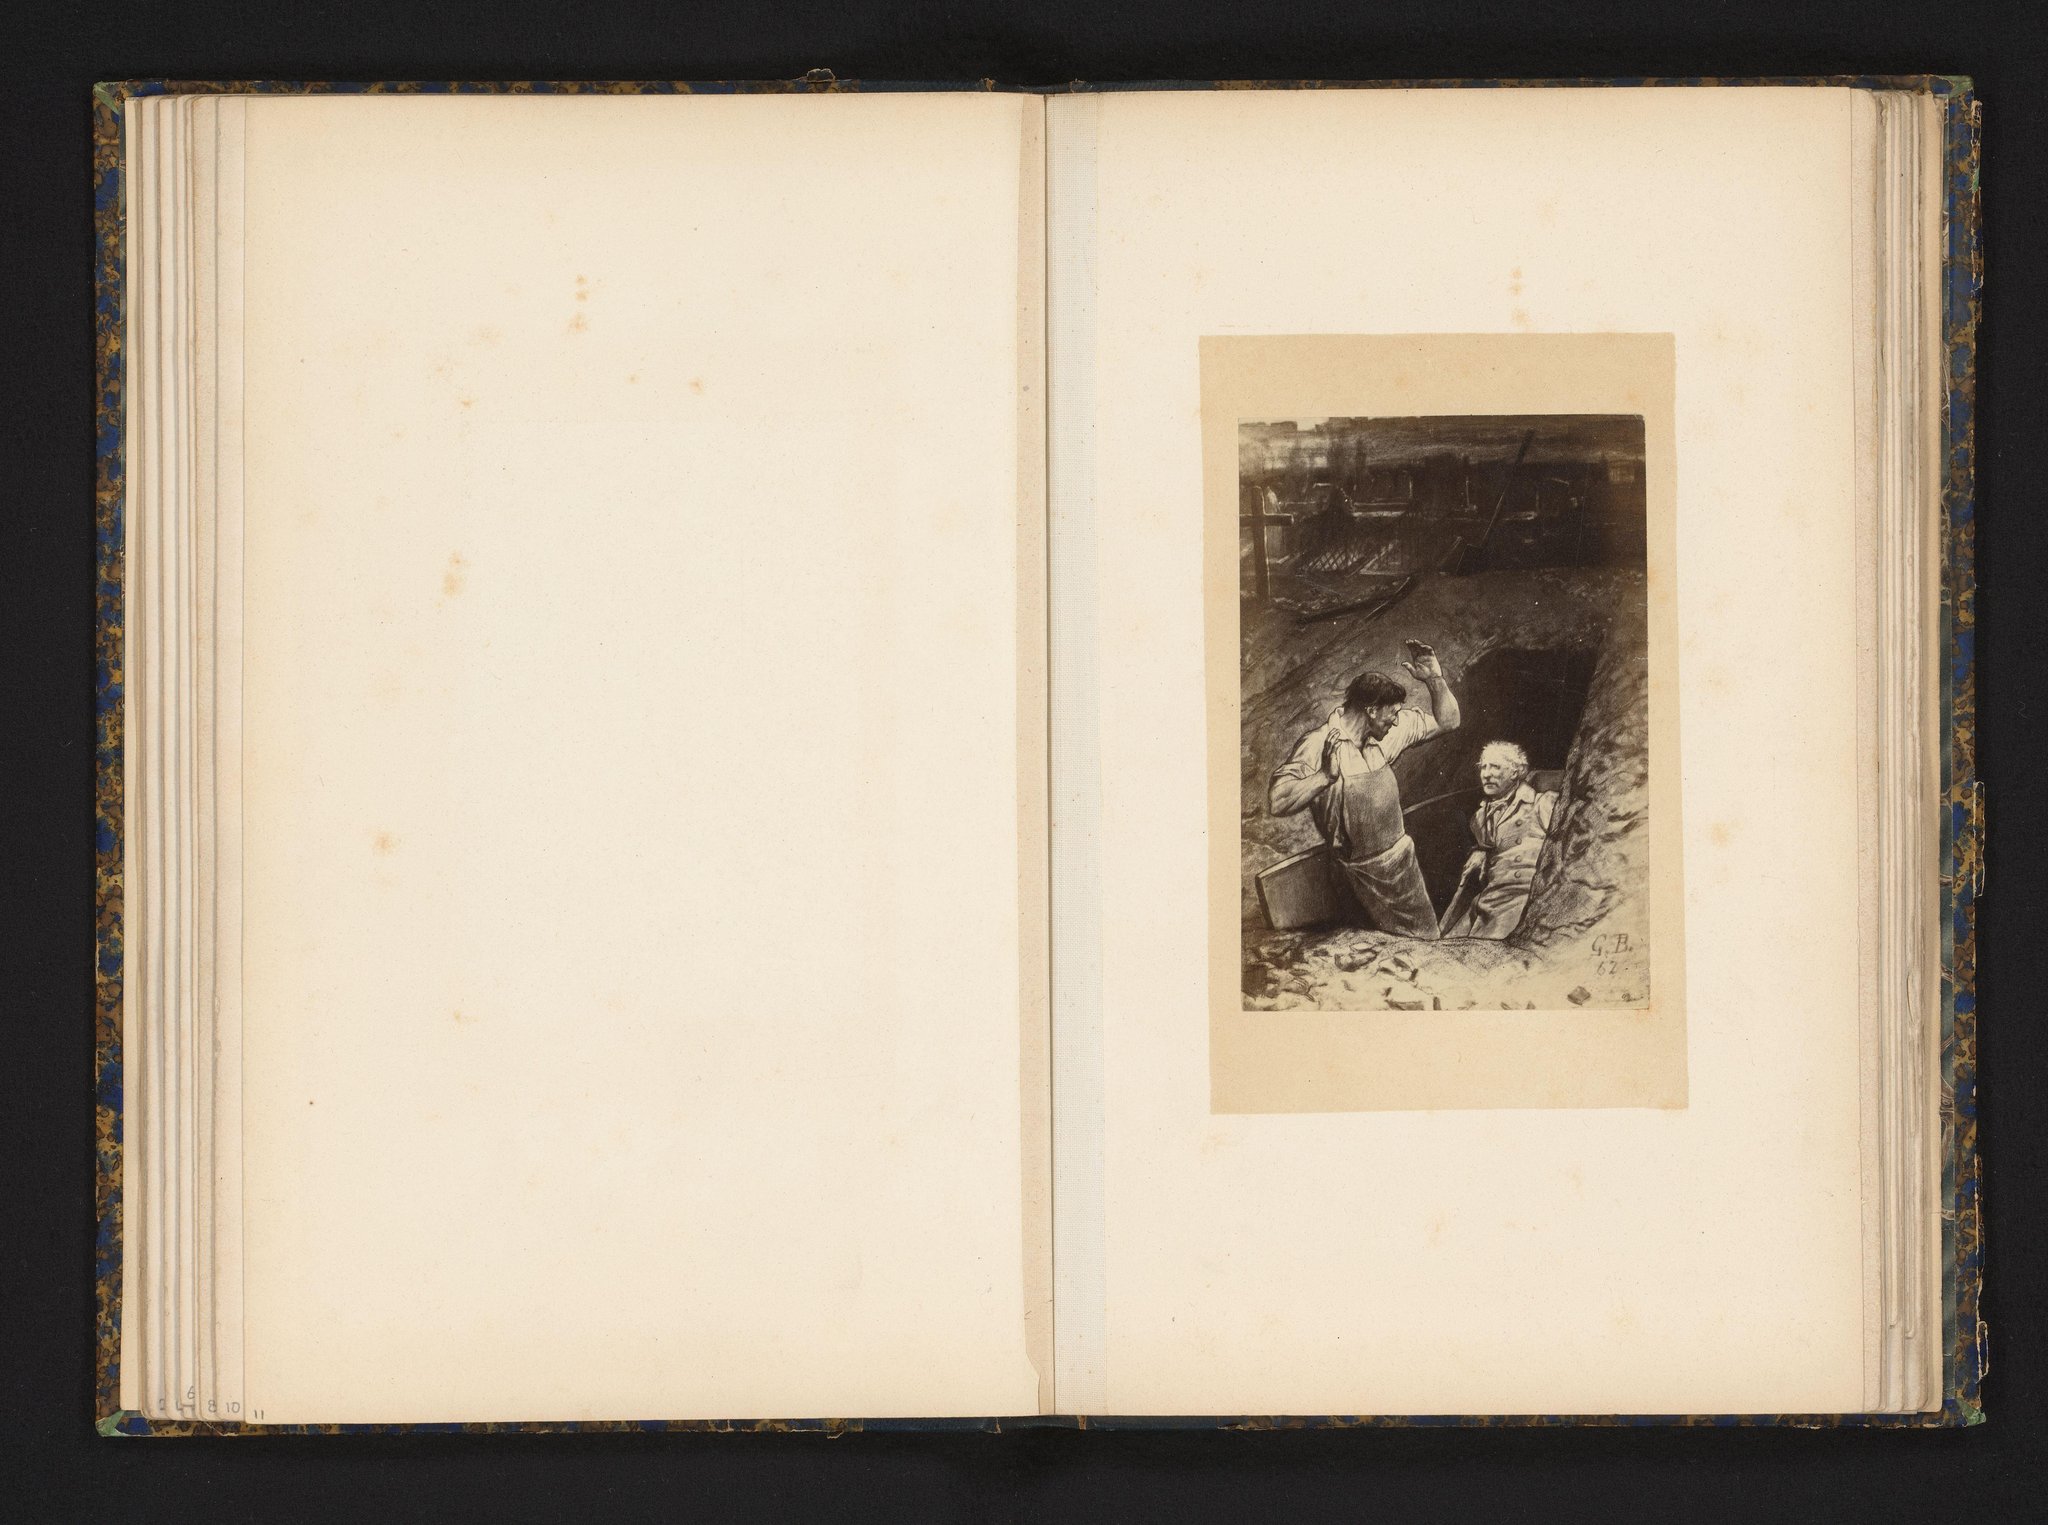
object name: photograph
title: Fotoreproductie van een tekening van een scène op een begraafplaats met Fauchelevent en Jean Valjean uit Les Misérables van Victor Hugo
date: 1862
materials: photographic support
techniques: albumen print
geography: paris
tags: literary characters and objects